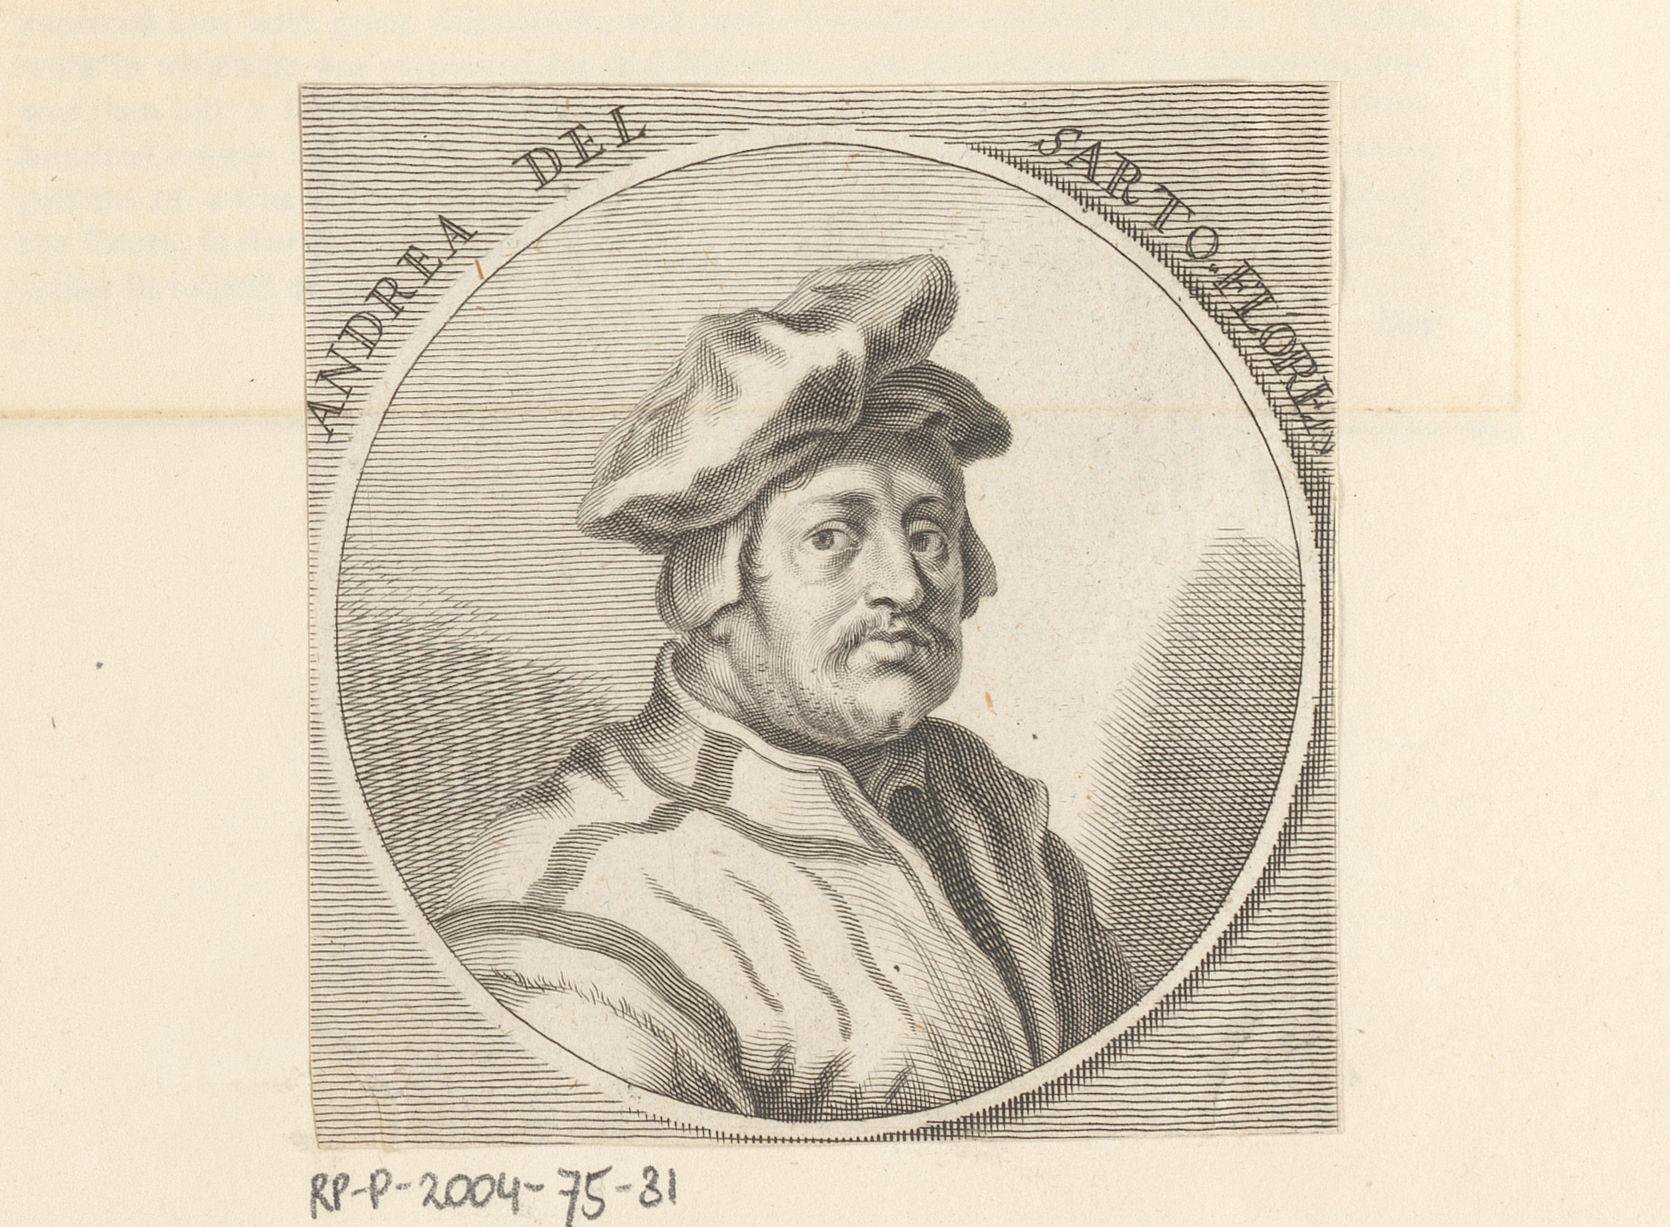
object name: book illustration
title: Portret van Andrea del Sarto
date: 1768-1775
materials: paper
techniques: engraving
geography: nuremberg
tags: painter, draughtsman, andrea del sarto, historical persons, portrait, self-portrait of painter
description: Prent uit: Sandrart, Joachim von. Teutsche Academie der Bau- Bildhauer- und Maler-Kunst: worinn die Regeln und Lehrsätze dieser Künste gegeben. 14 dln. Neurenberg: erven Johann Andreas Endter, [1774], dl. 7, p. N. Eerdere staat van prent gebruikt in: Sandrart, Joachim von. Teutsche Academie der Edlen Bau- Bild- und Mahlerey-Künste (...). Neurenberg: Jakob von Sandrart, [1675-1679]. De samensteller heeft deze prent in het album geplakt als illustratie bij: Pilkington, Matthew en Johann Heinrich Füssli. A dictionary of painters, from the revival of the art to the present period. 4 dln. Londen: John Crowder, 1805, dl. 4, p. 588.